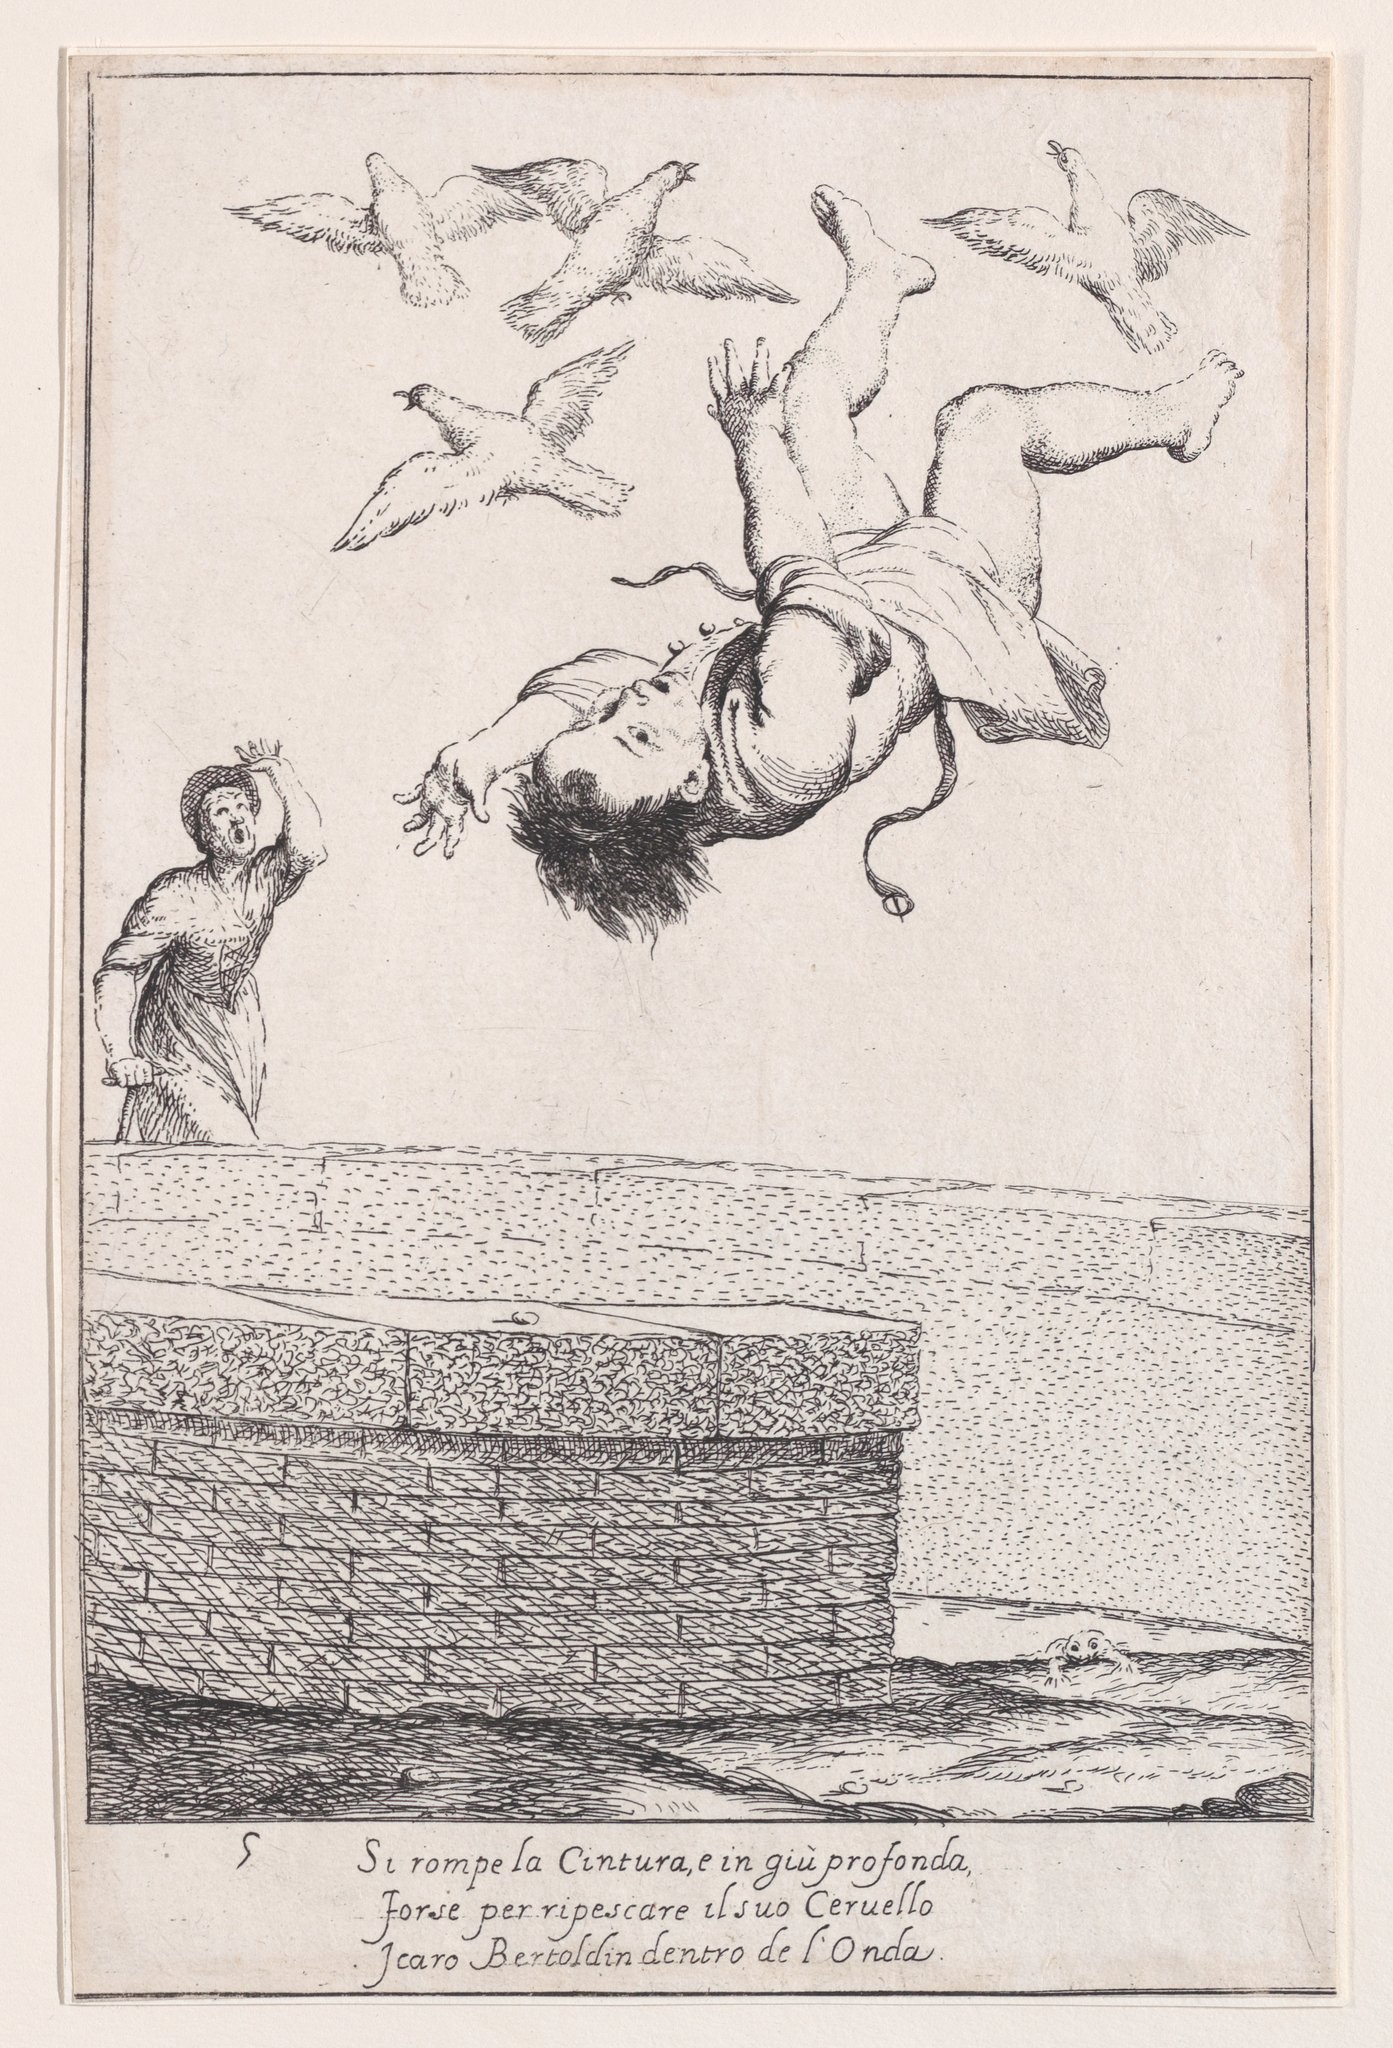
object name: print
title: Plate 11: Bertoldino falling into the fish pond, from "Bertoldo, Bertoldino, and Cacasenno"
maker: giuseppe maria crespi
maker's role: artist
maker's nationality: italian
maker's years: 1665-1747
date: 1705-1715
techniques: etching